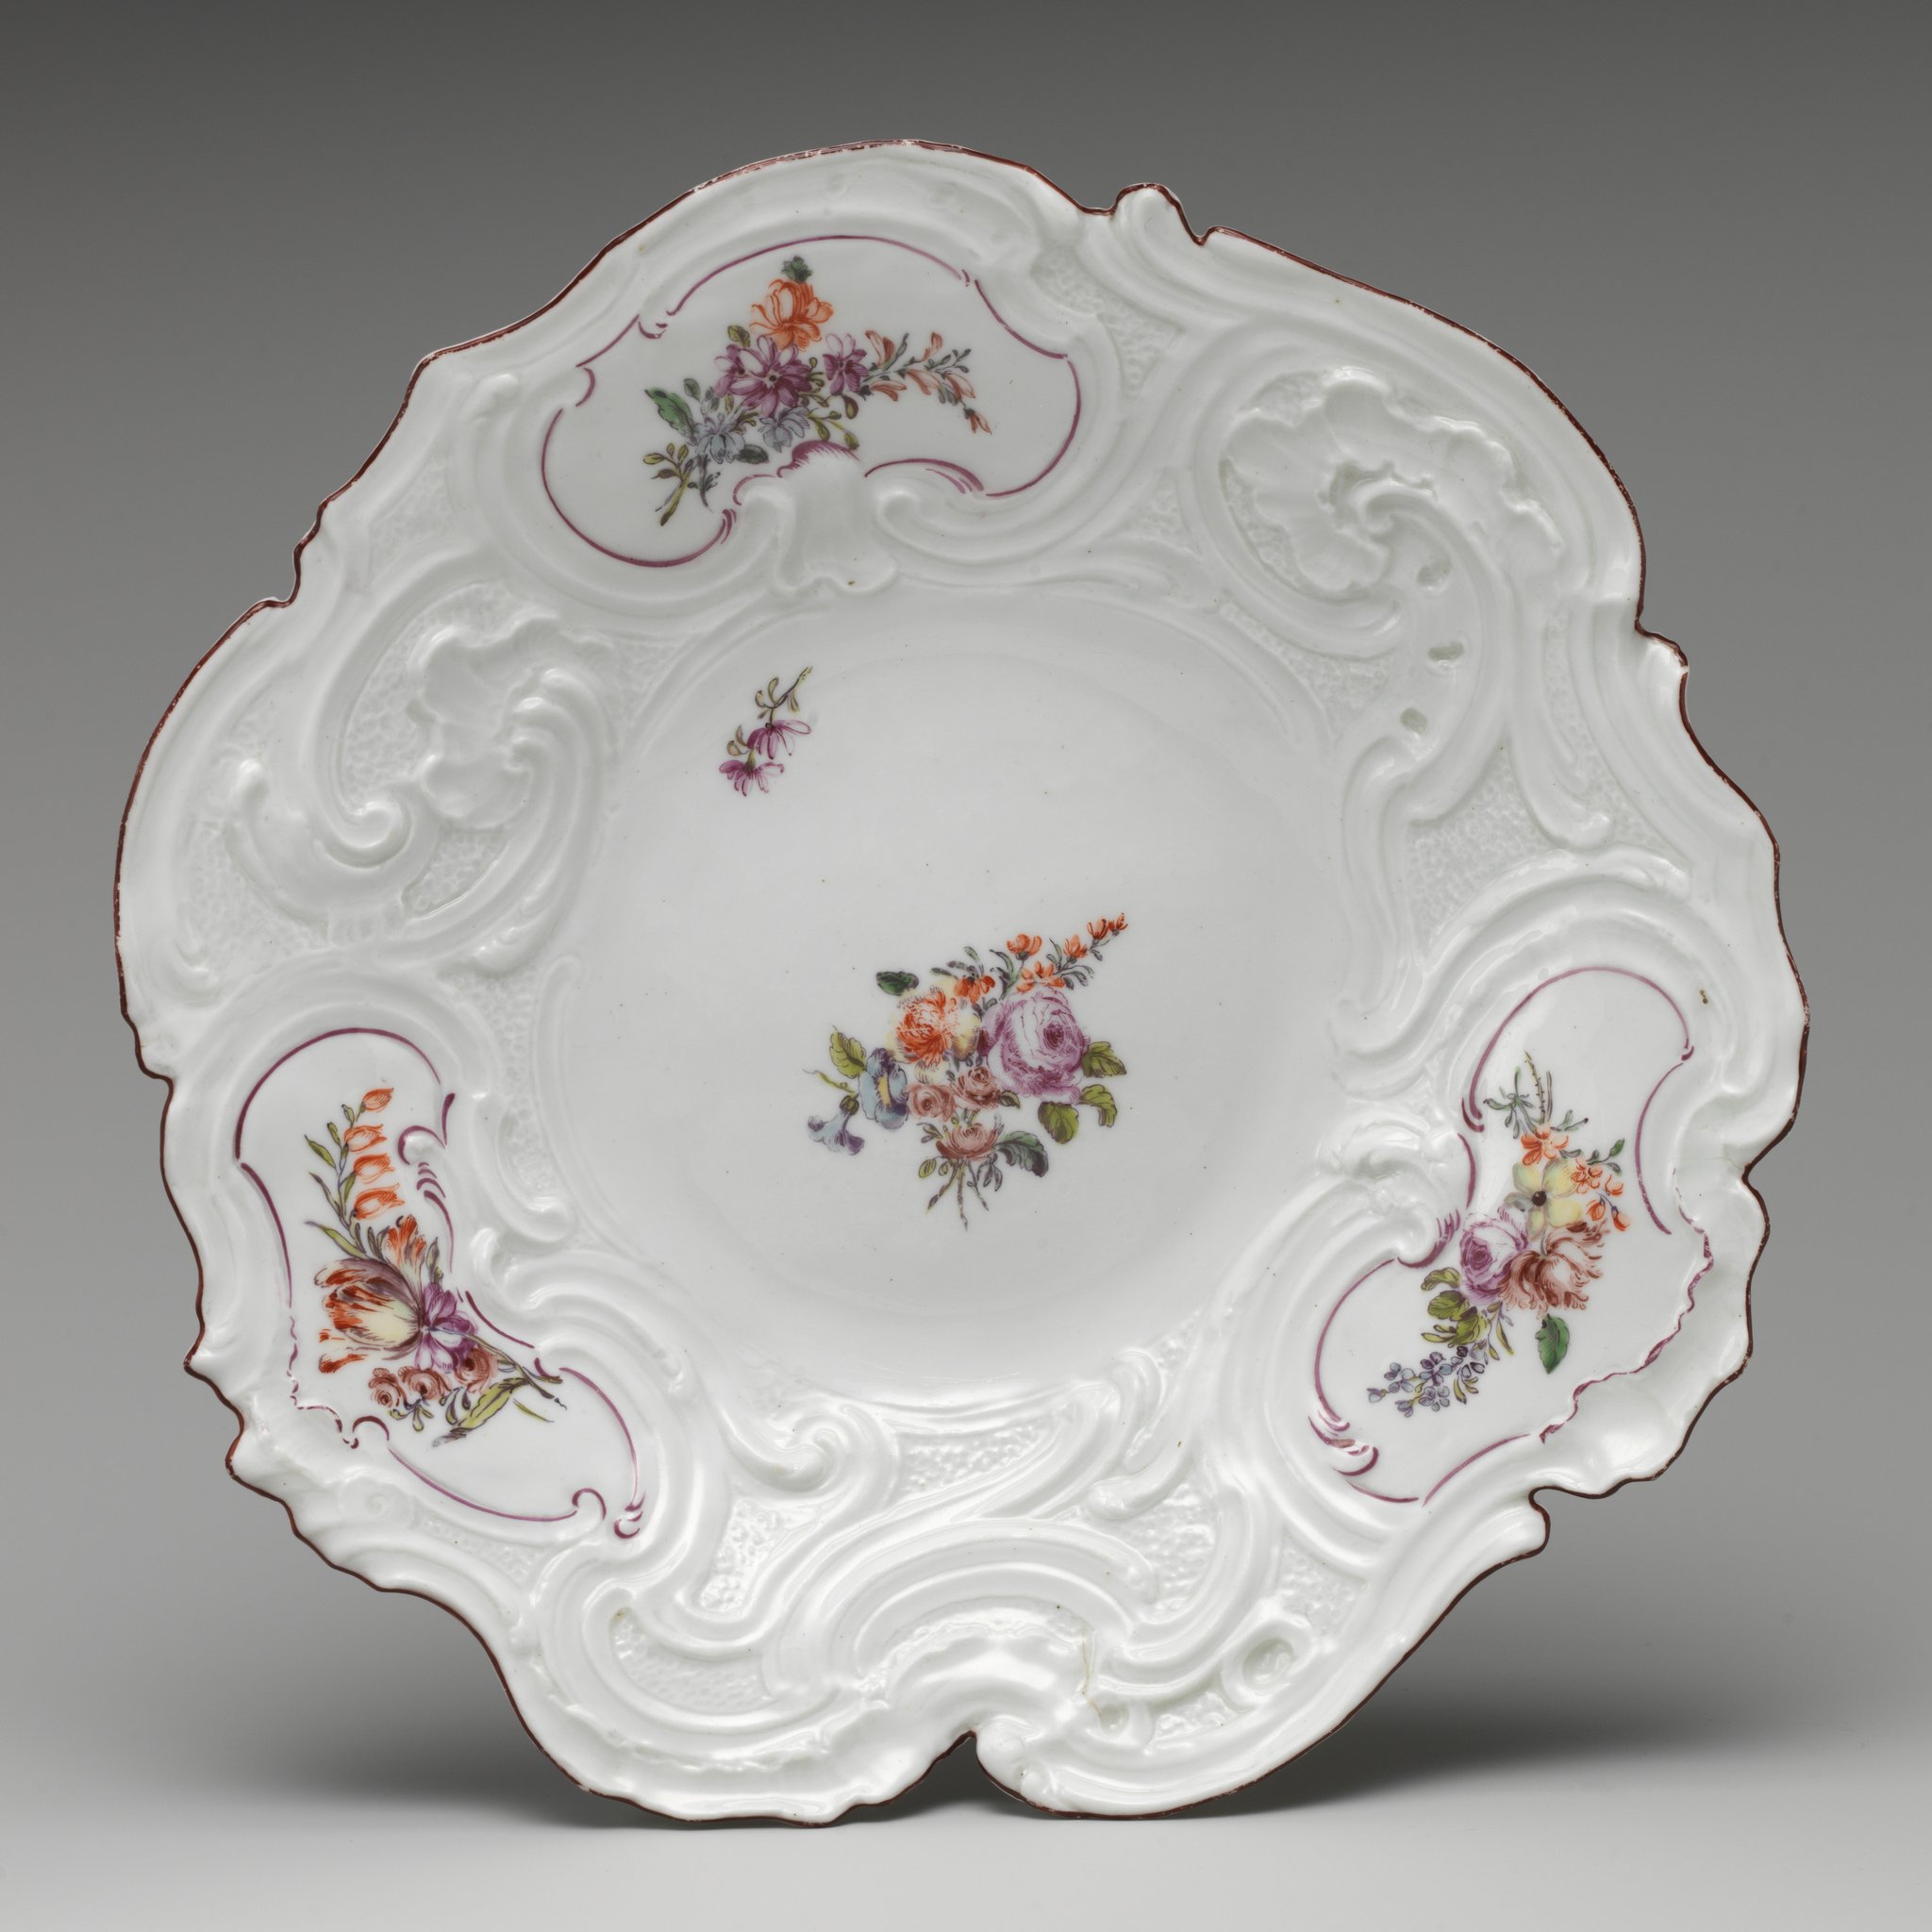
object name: plate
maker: chelsea porcelain manufactory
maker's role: factory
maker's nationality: british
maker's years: 1744-1784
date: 1752-1756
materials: soft paste porcelain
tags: flowers